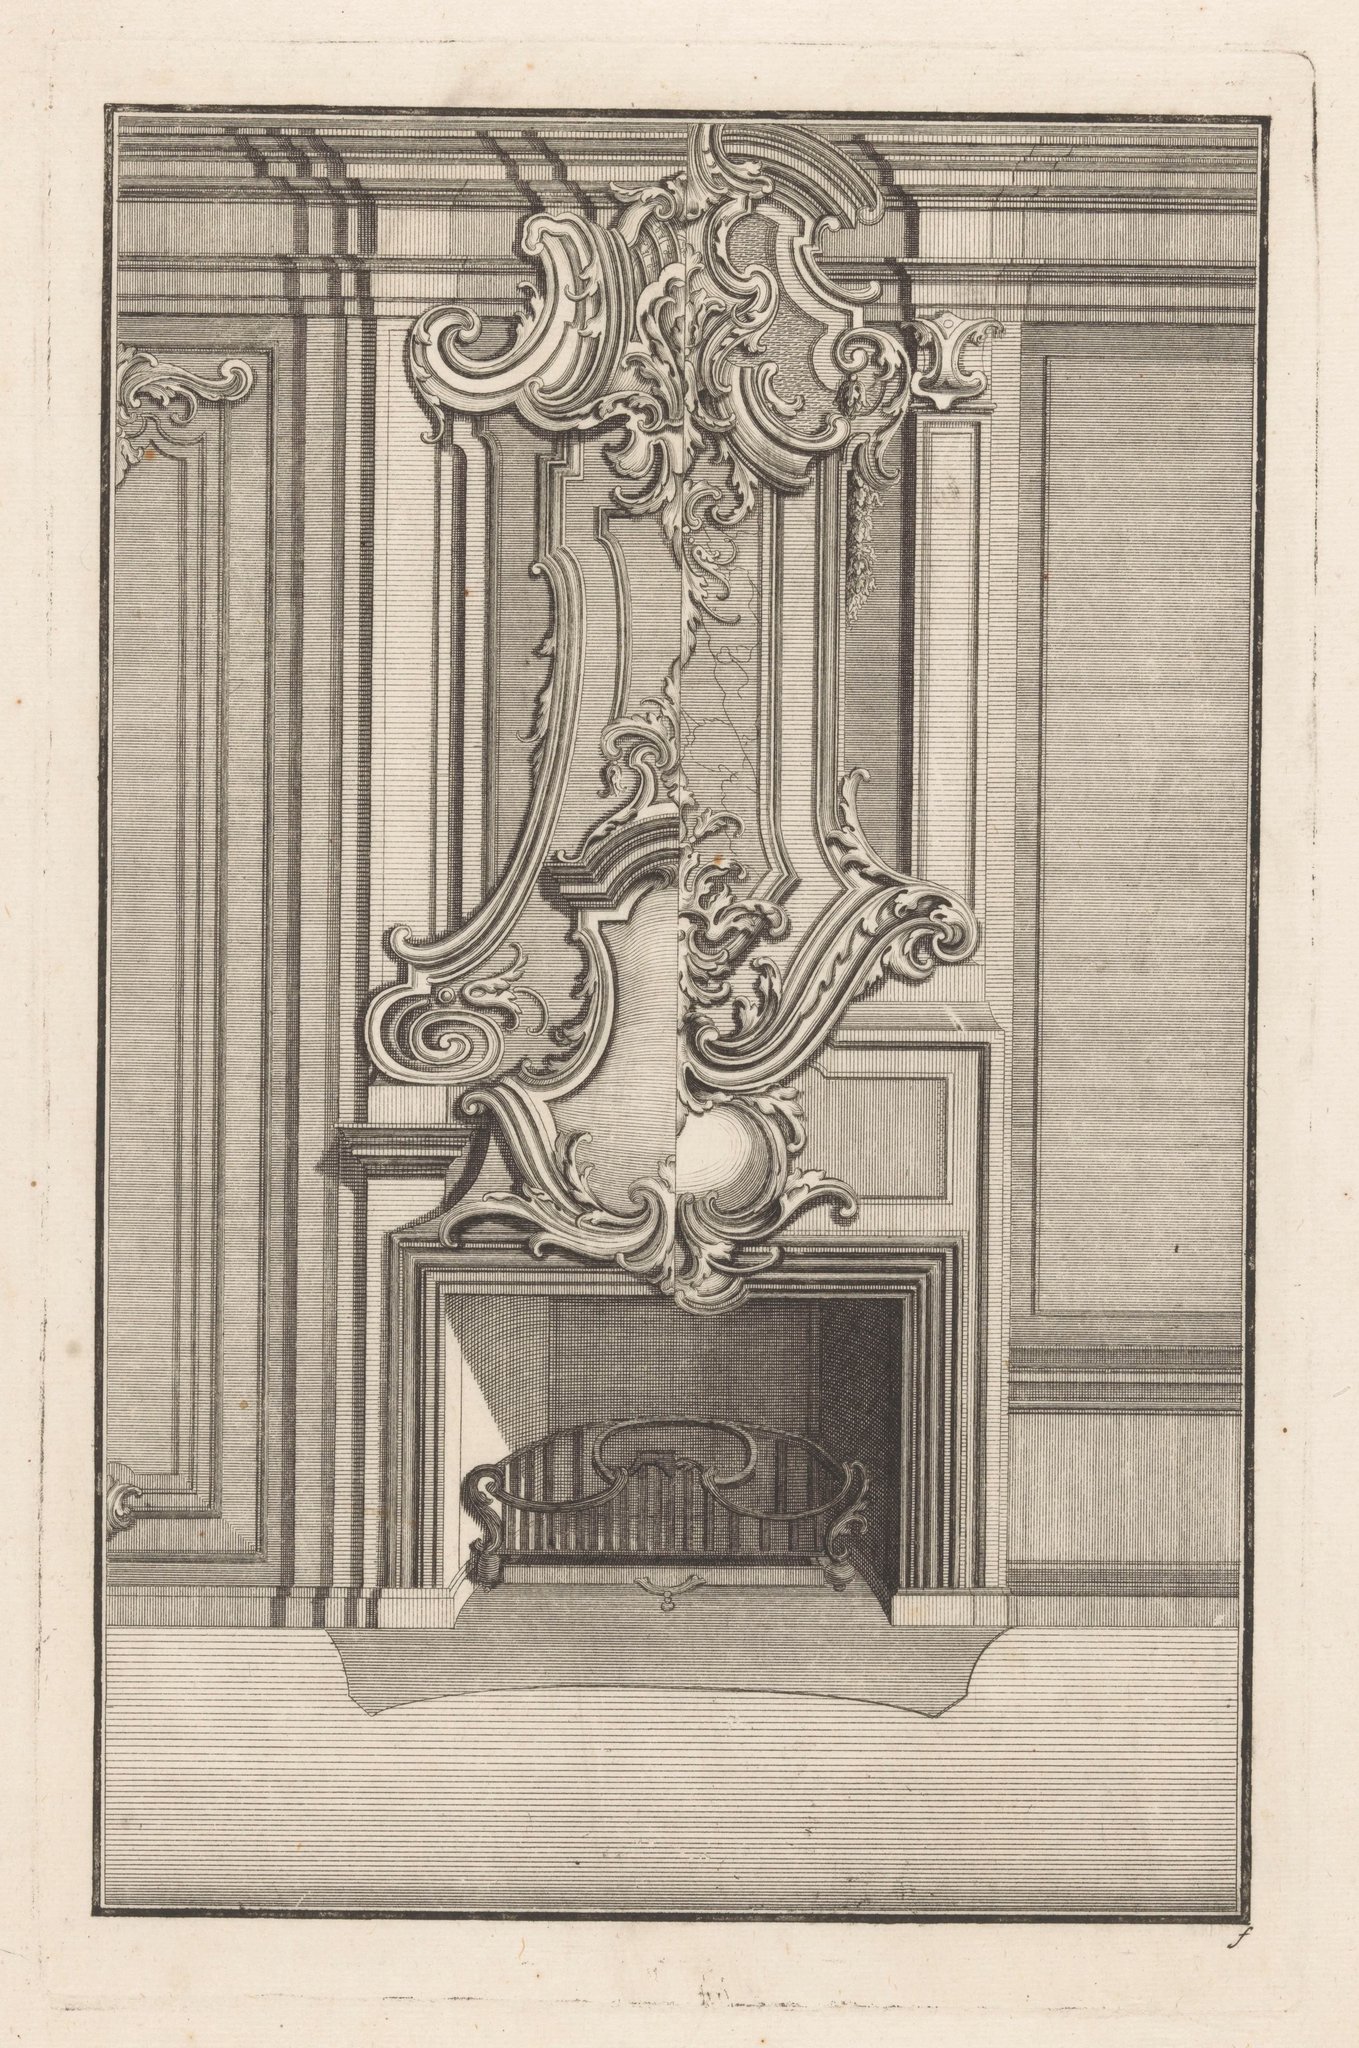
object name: print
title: Second Livre de nouveaux Cheminées (...)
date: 1726-1741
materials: paper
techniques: engraving, etching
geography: nuremberg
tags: rocaille ornament, fire-screen, open hearth, fire-place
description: Prent uit: Schübler, Johann Jakob. Second Livre de nouveaux Cheminées (...). [Neurenberg]: Weigel, weduwe Johann Christoph, [na 1726].